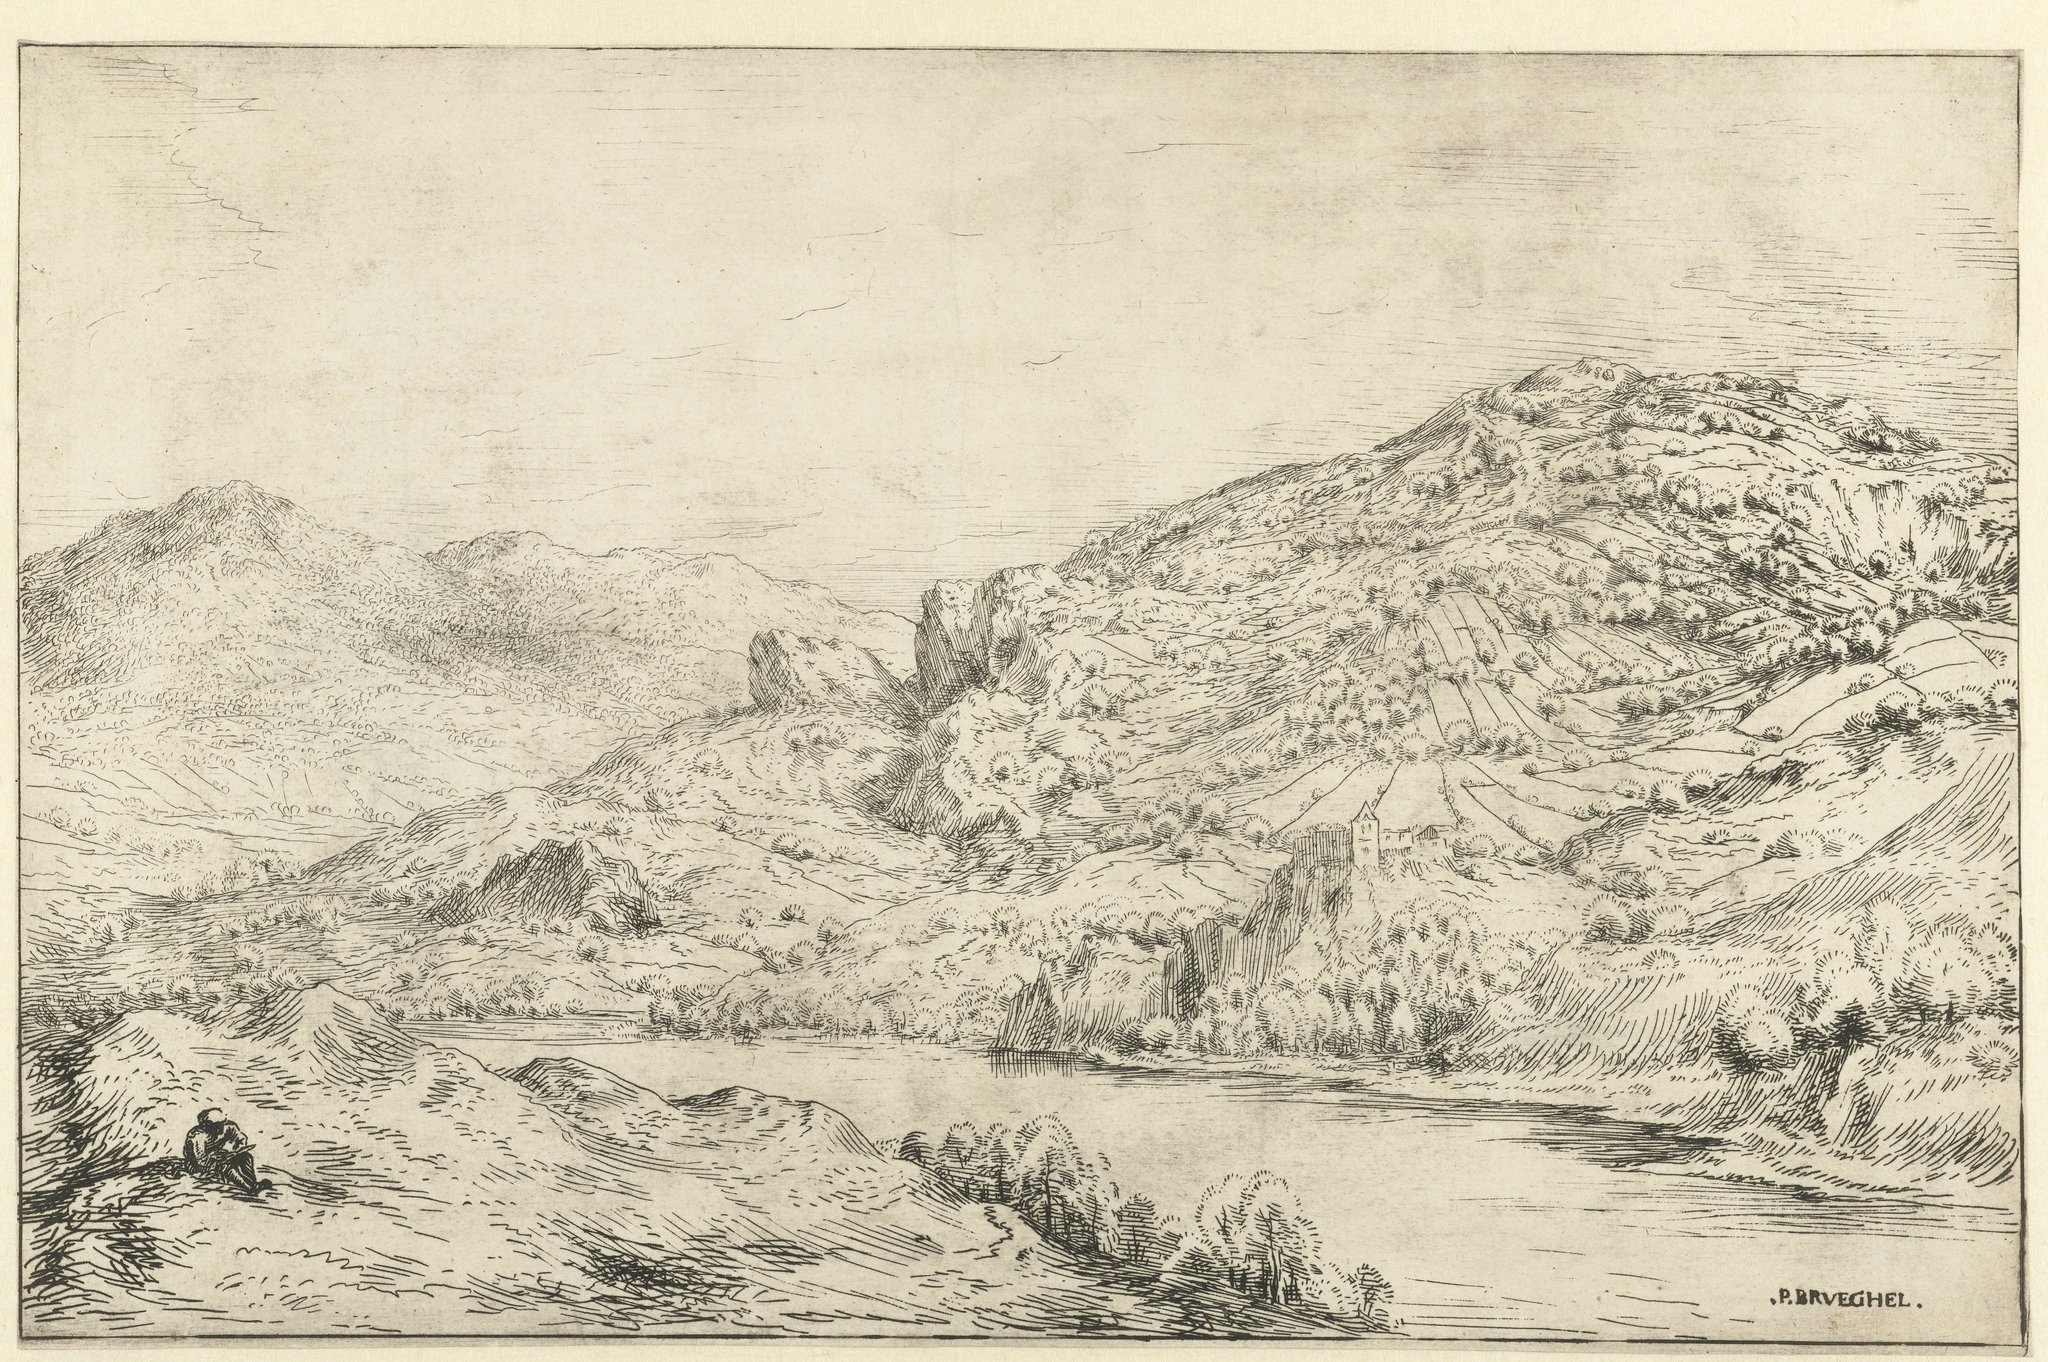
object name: print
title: Bergachtig landschap met schilder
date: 1579-1699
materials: paper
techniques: etching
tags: dale, valley, painter making preliminary designs, sketching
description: Bergachtig landschap, door rivier in twee delen gescheiden. Aan de rivier zit een man die schetst.